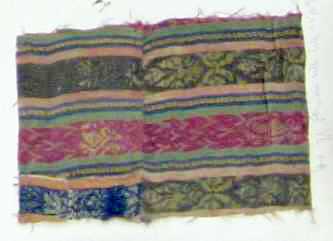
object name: textile fragment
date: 1601-1800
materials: silk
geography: iran